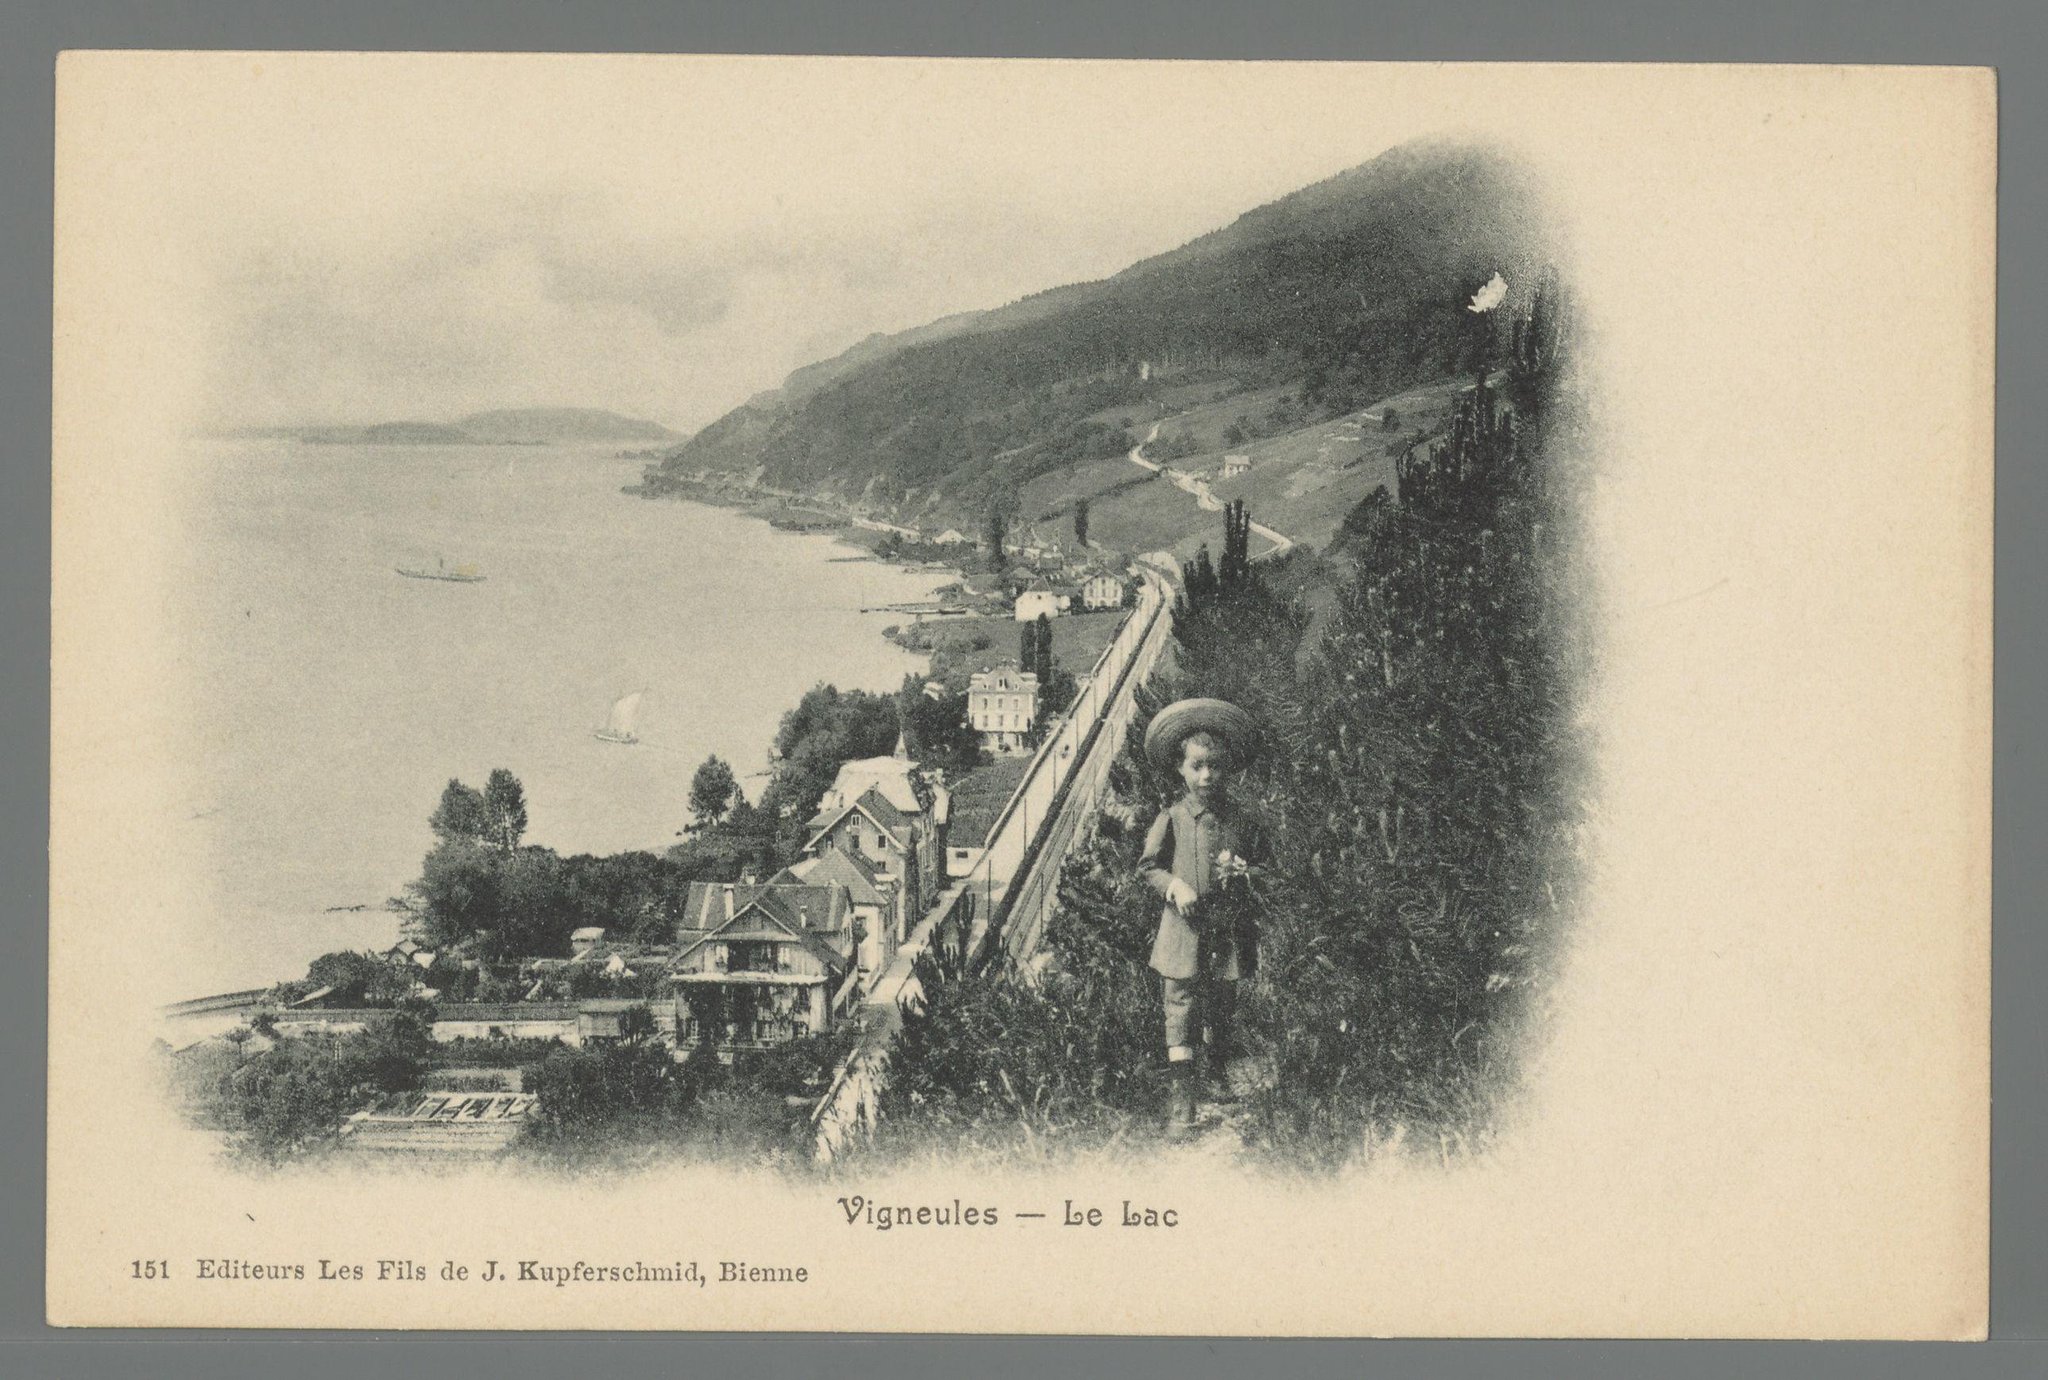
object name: photomechanical print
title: Vigneules. Le Lac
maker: Anonymous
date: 1890-1905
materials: cardboard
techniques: photograph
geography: biel/bienne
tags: prospect of village, silhouette of village, prospect of village, silhouette of village (+ city(-scape) with figures, staffage)